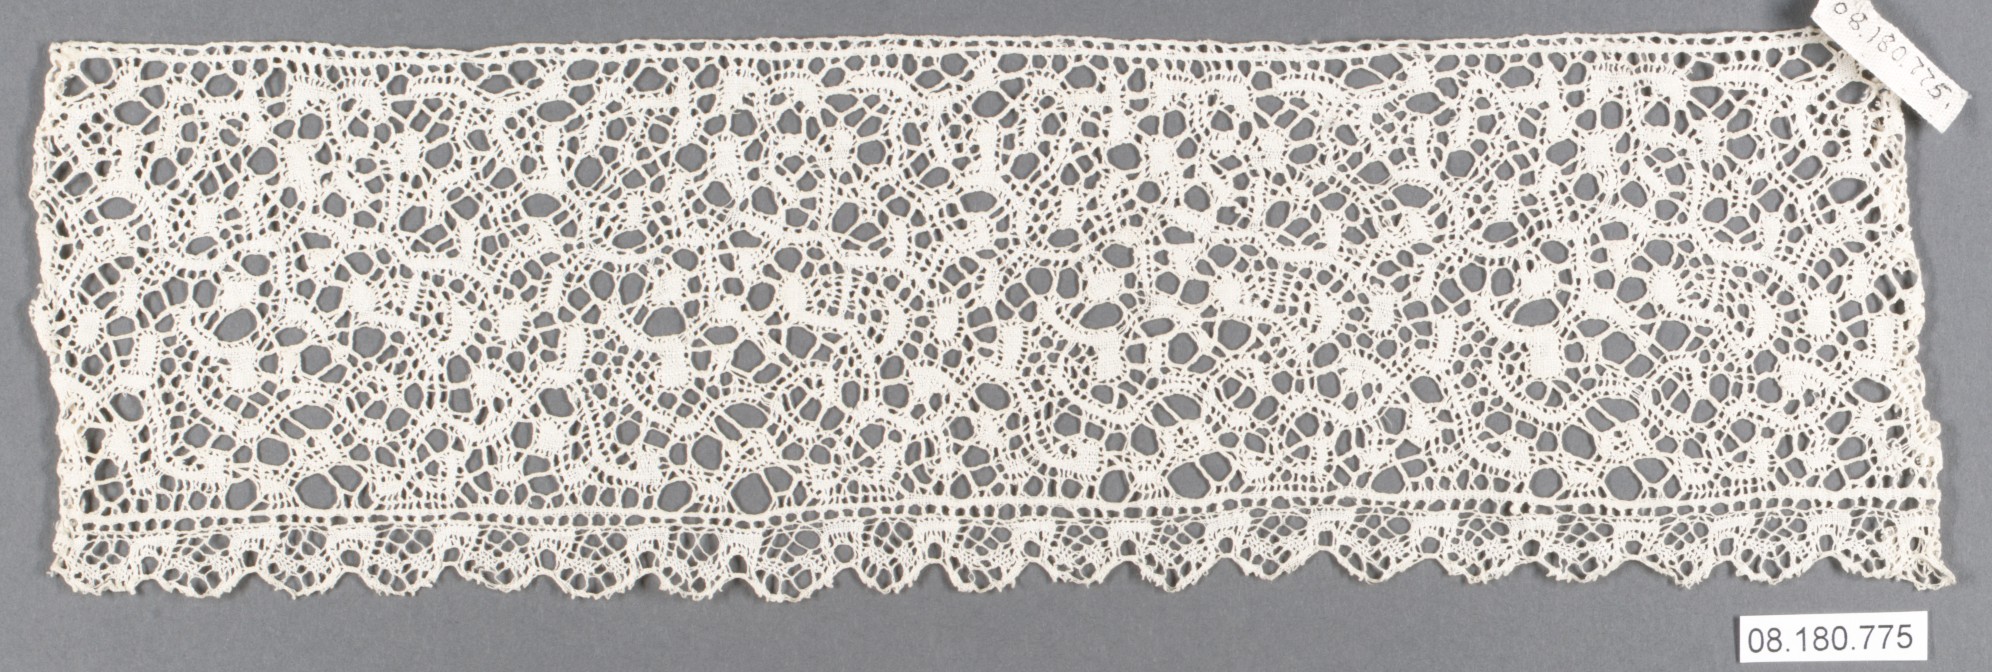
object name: border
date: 1701-1800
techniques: lace